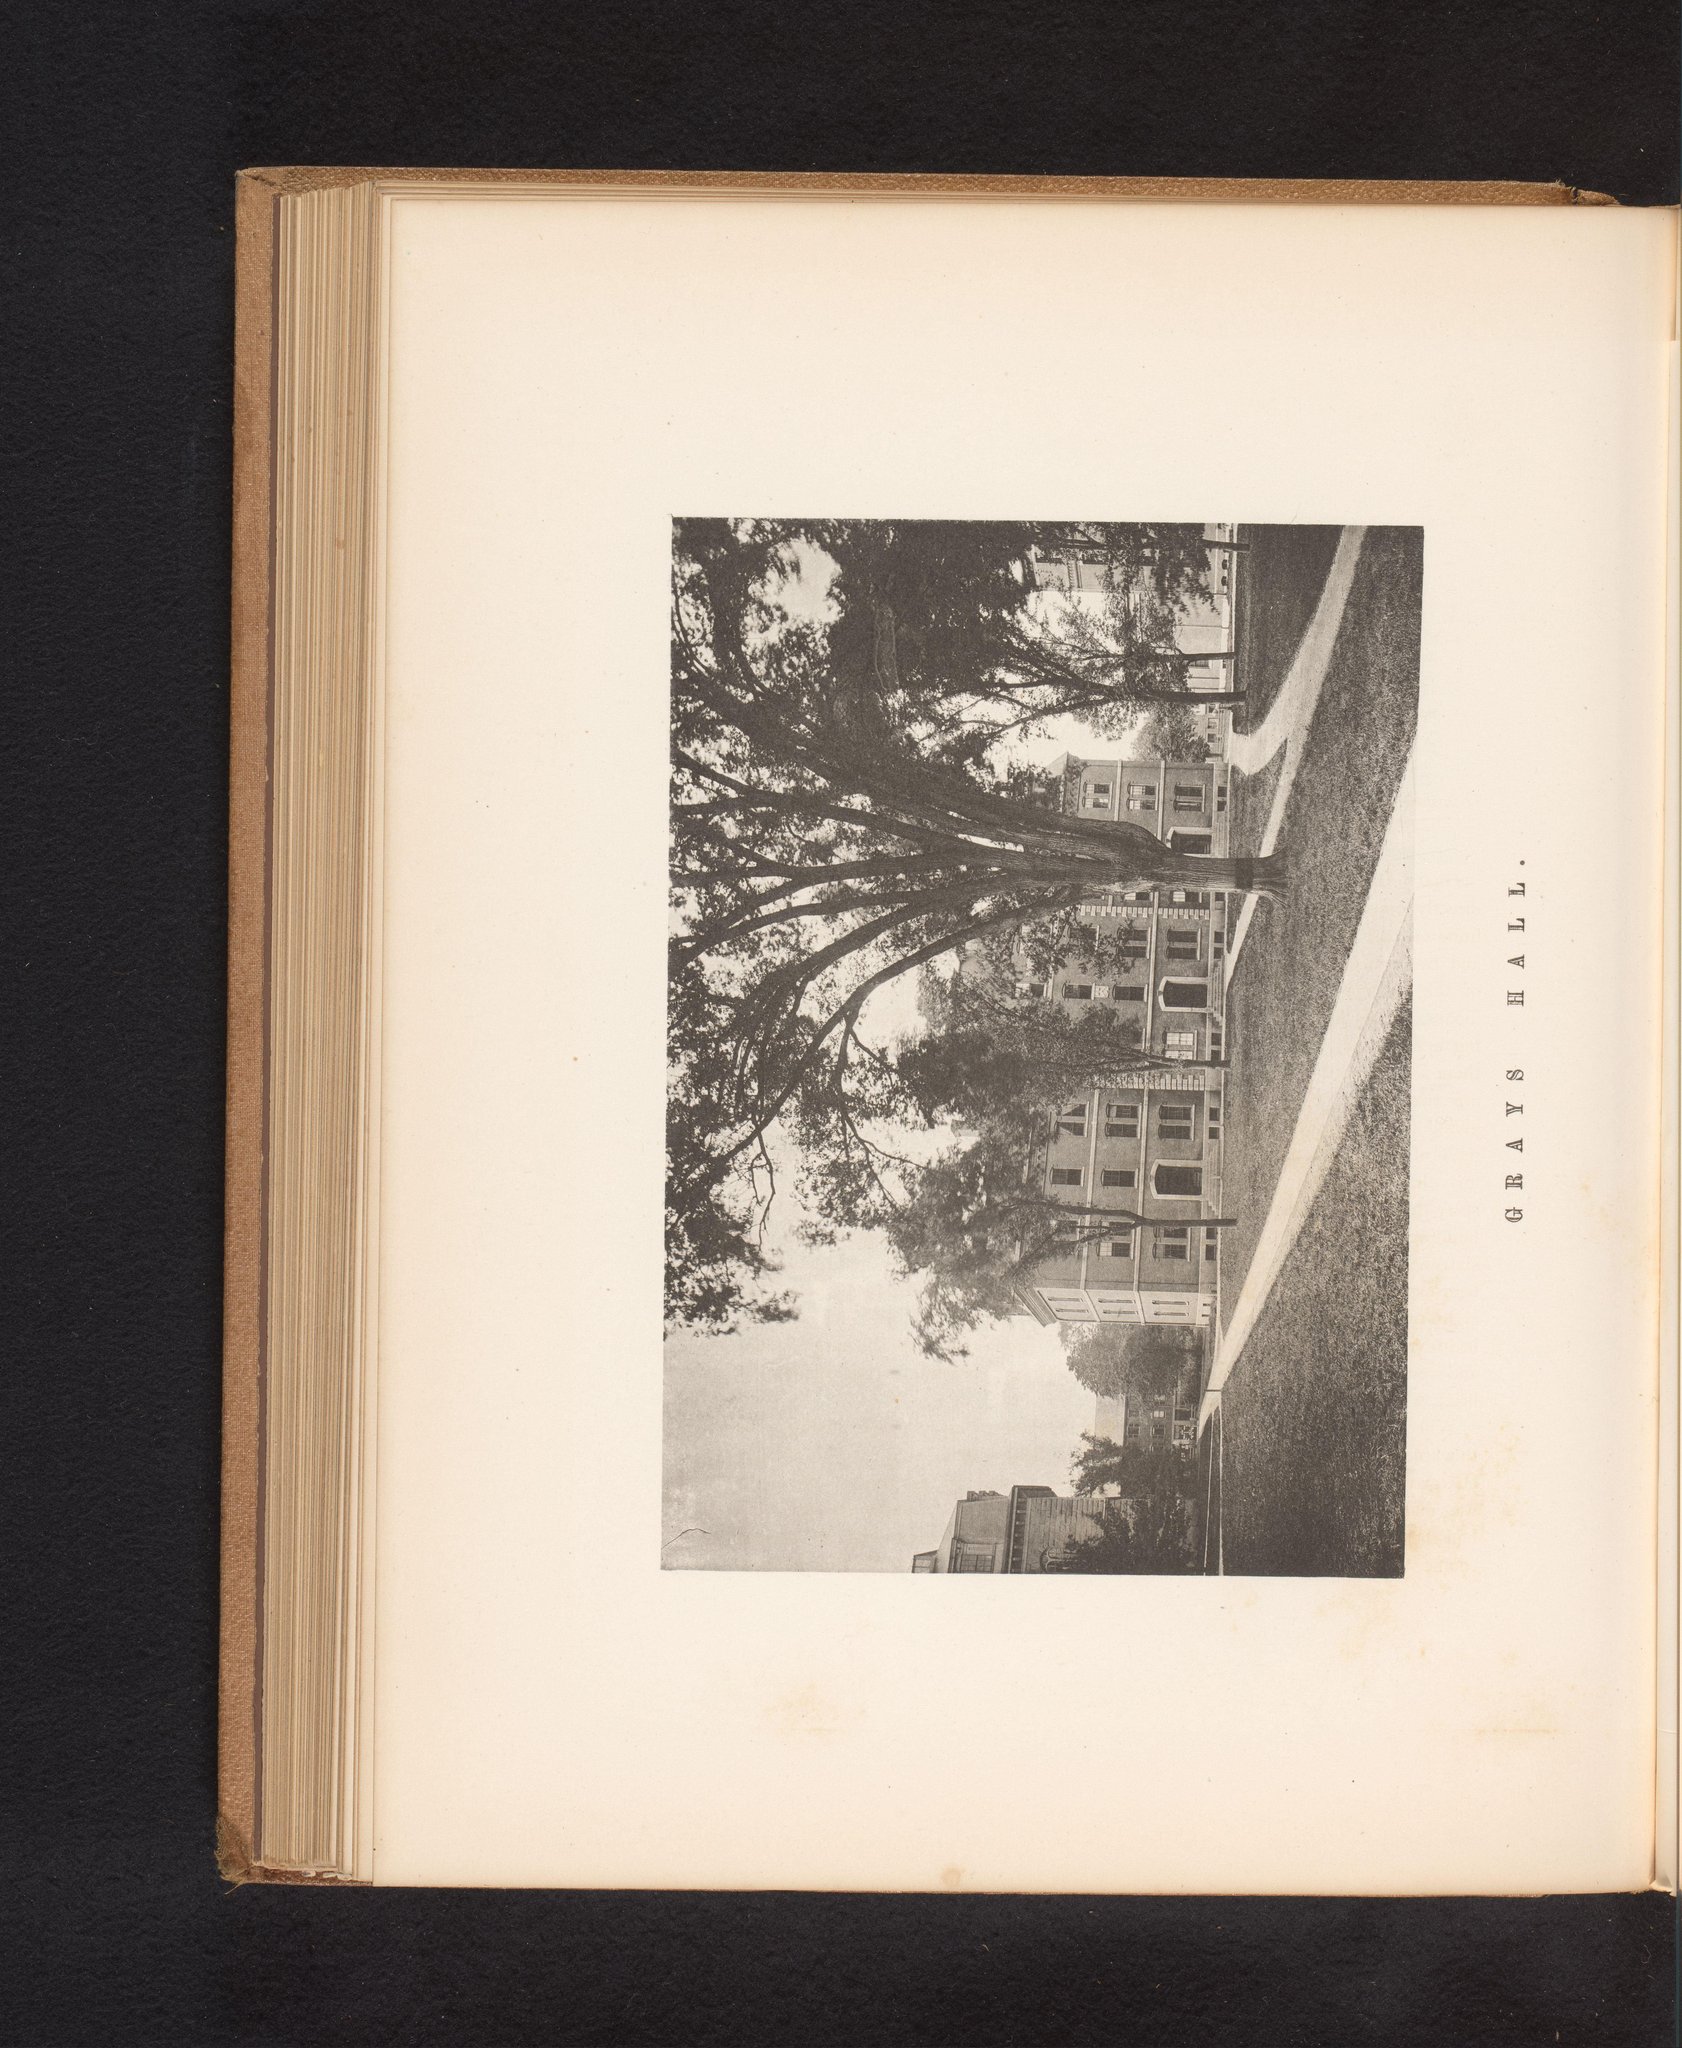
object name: page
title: Grays Hall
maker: Anonymous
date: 1870-1875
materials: paper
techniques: photograph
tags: university building, college